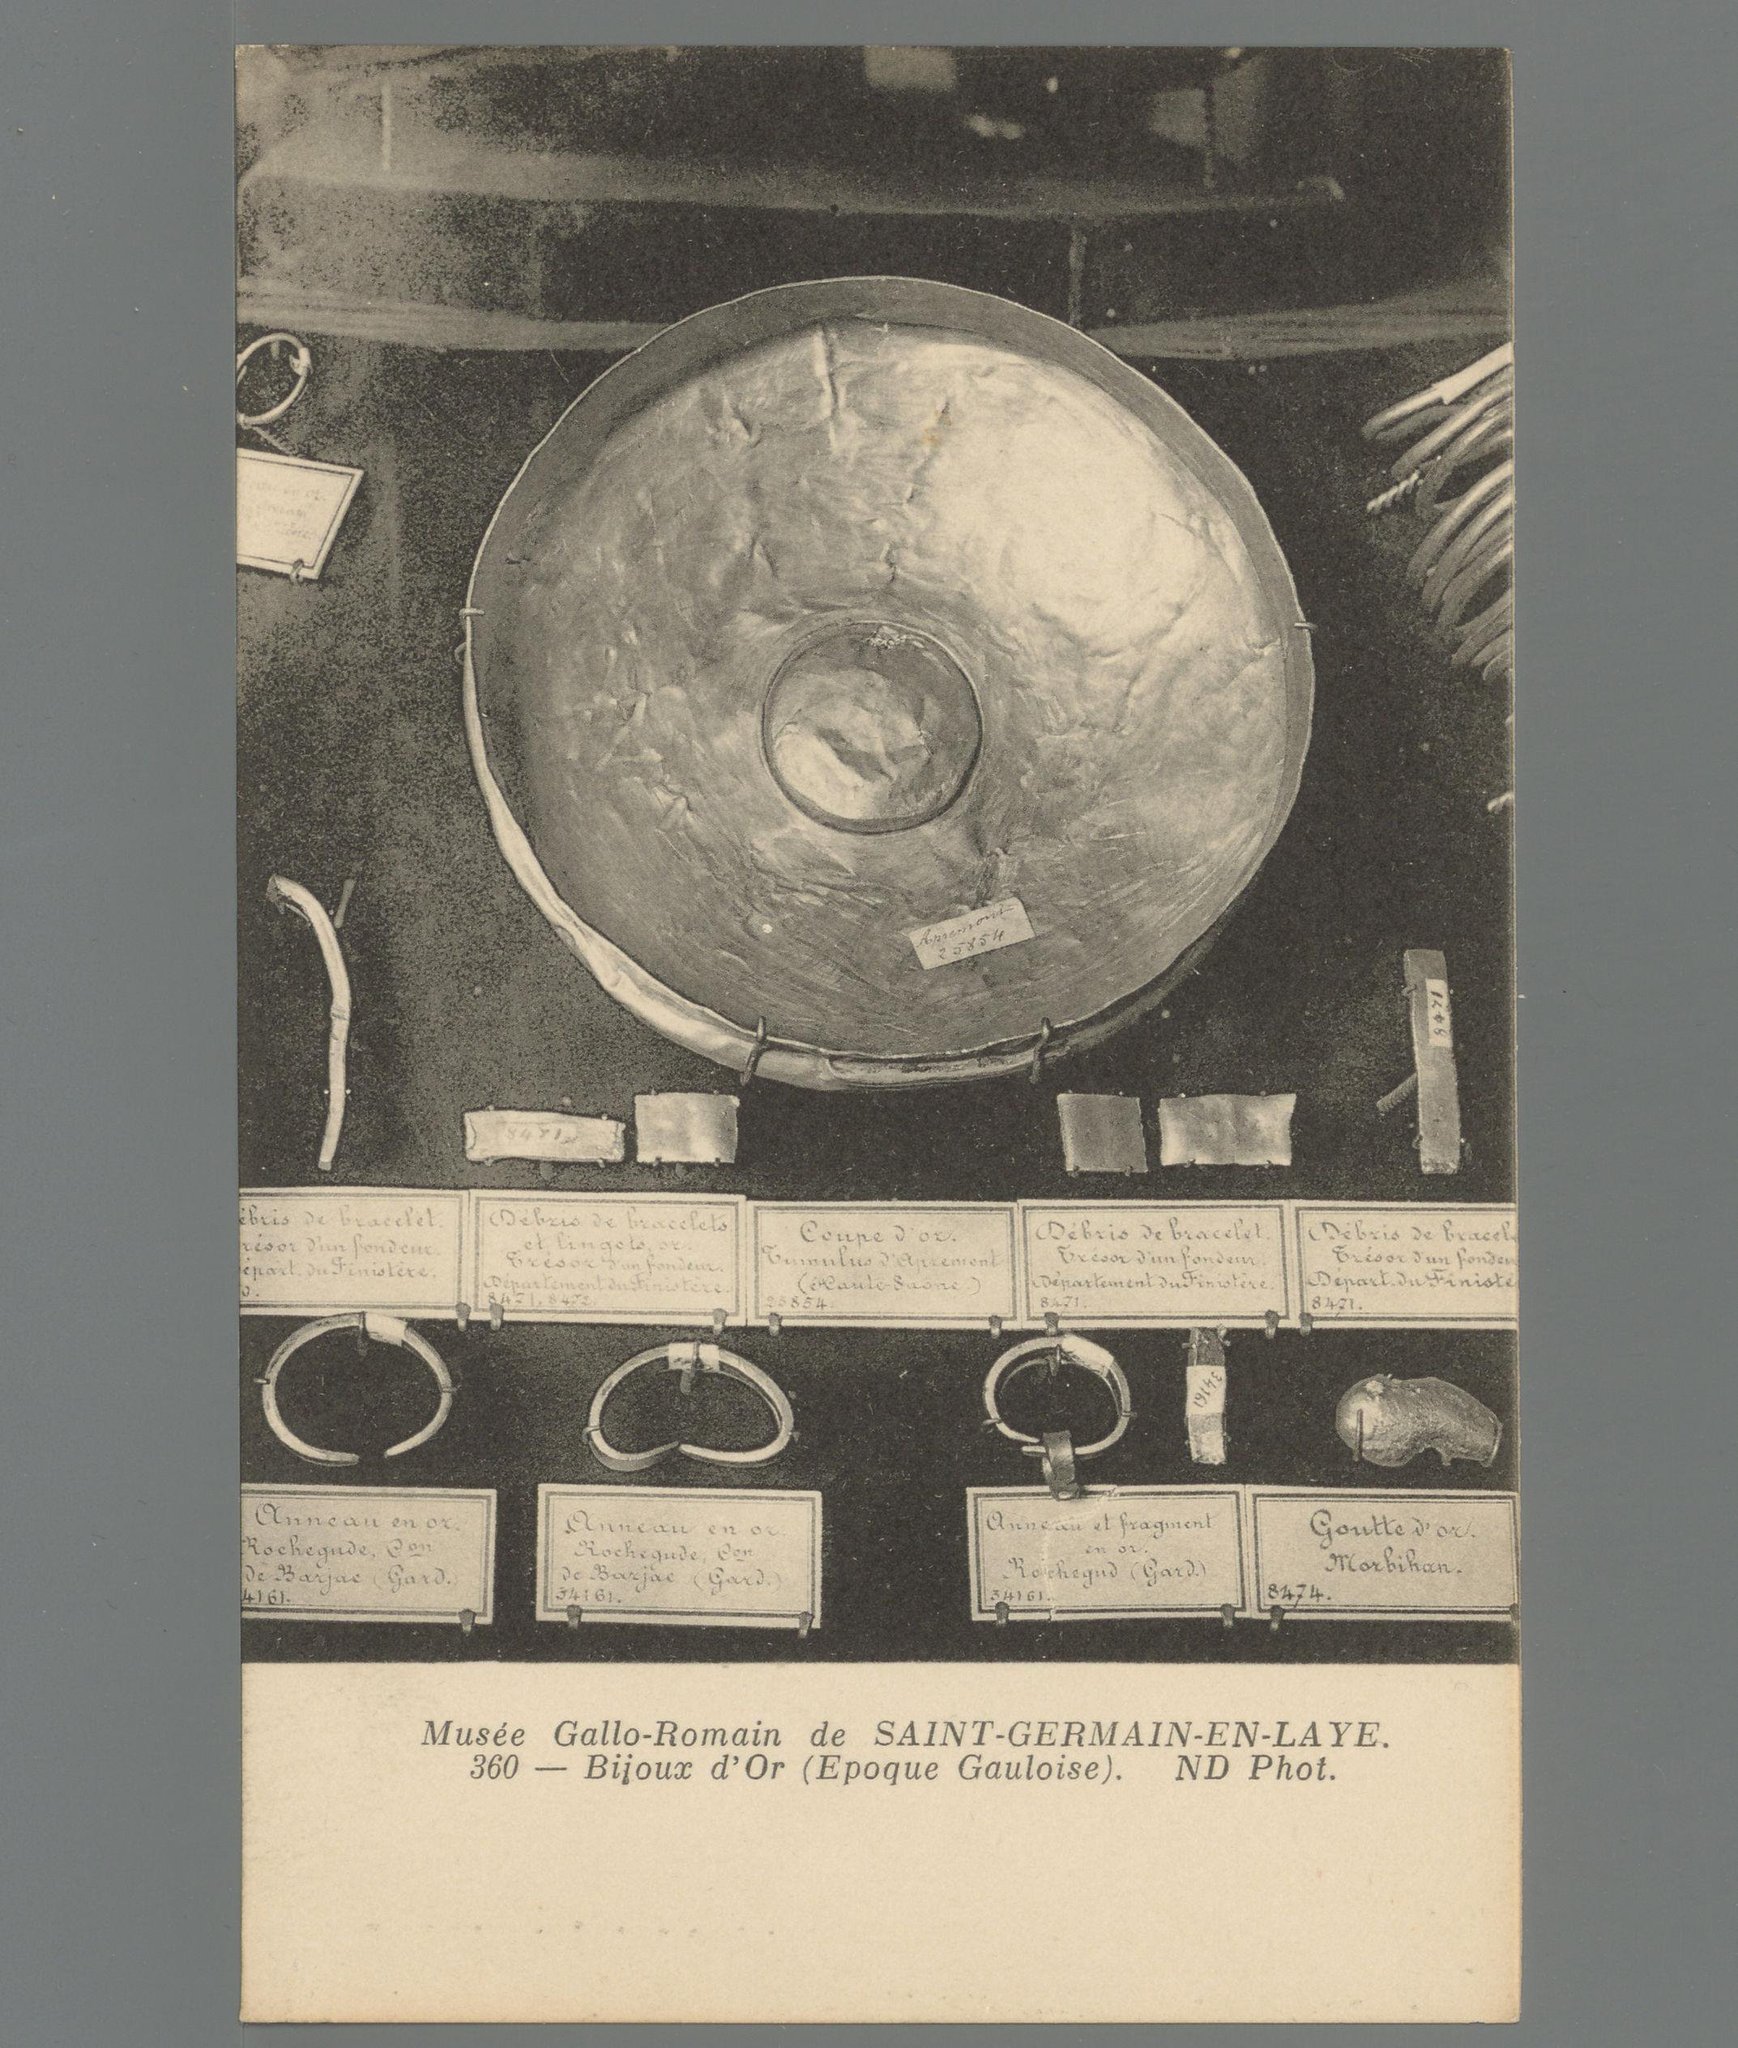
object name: photomechanical print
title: Bijoux d'Or (Epoque Gauloise)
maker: Anonymous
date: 1903-1918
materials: cardboard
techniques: photograph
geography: saint-germain-en-laye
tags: ornaments, jewels, permanent exhibition, museum, minerals and metals: gold